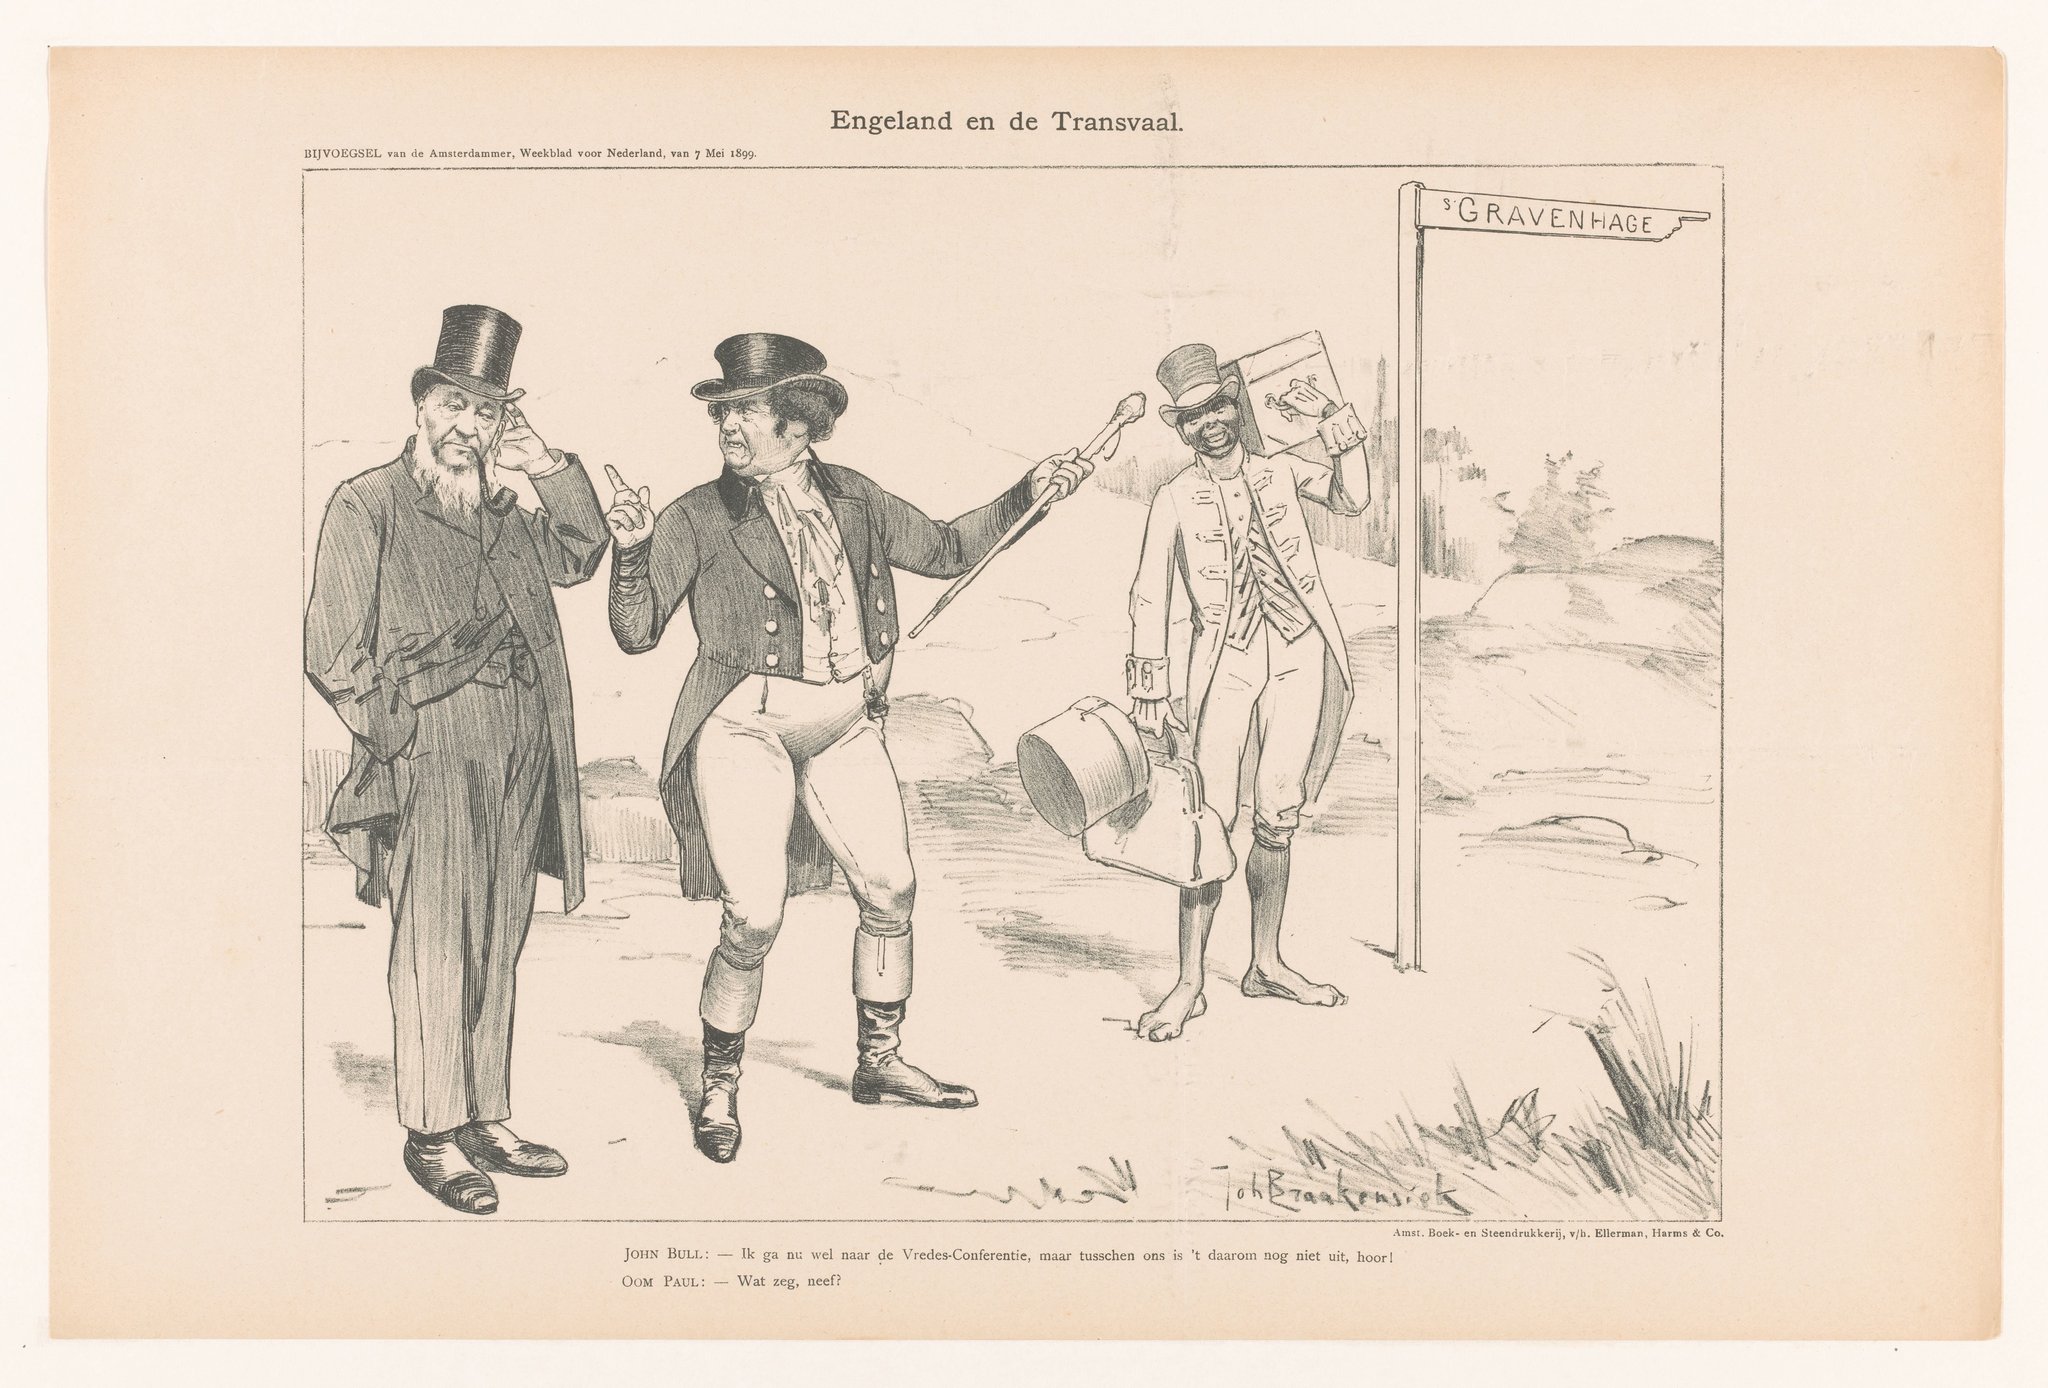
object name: cartoon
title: Engeland en de Transvaal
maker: johan braakensiek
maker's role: draughtsman, print maker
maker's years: 1858-1940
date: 1899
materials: paper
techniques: lithograph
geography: amsterdam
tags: historical persons, political caricatures and satires, england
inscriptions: date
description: Prent uit het bijvoegsel van: De Amsterdammer. Weekblad voor Nederland, 7 mei 1899.